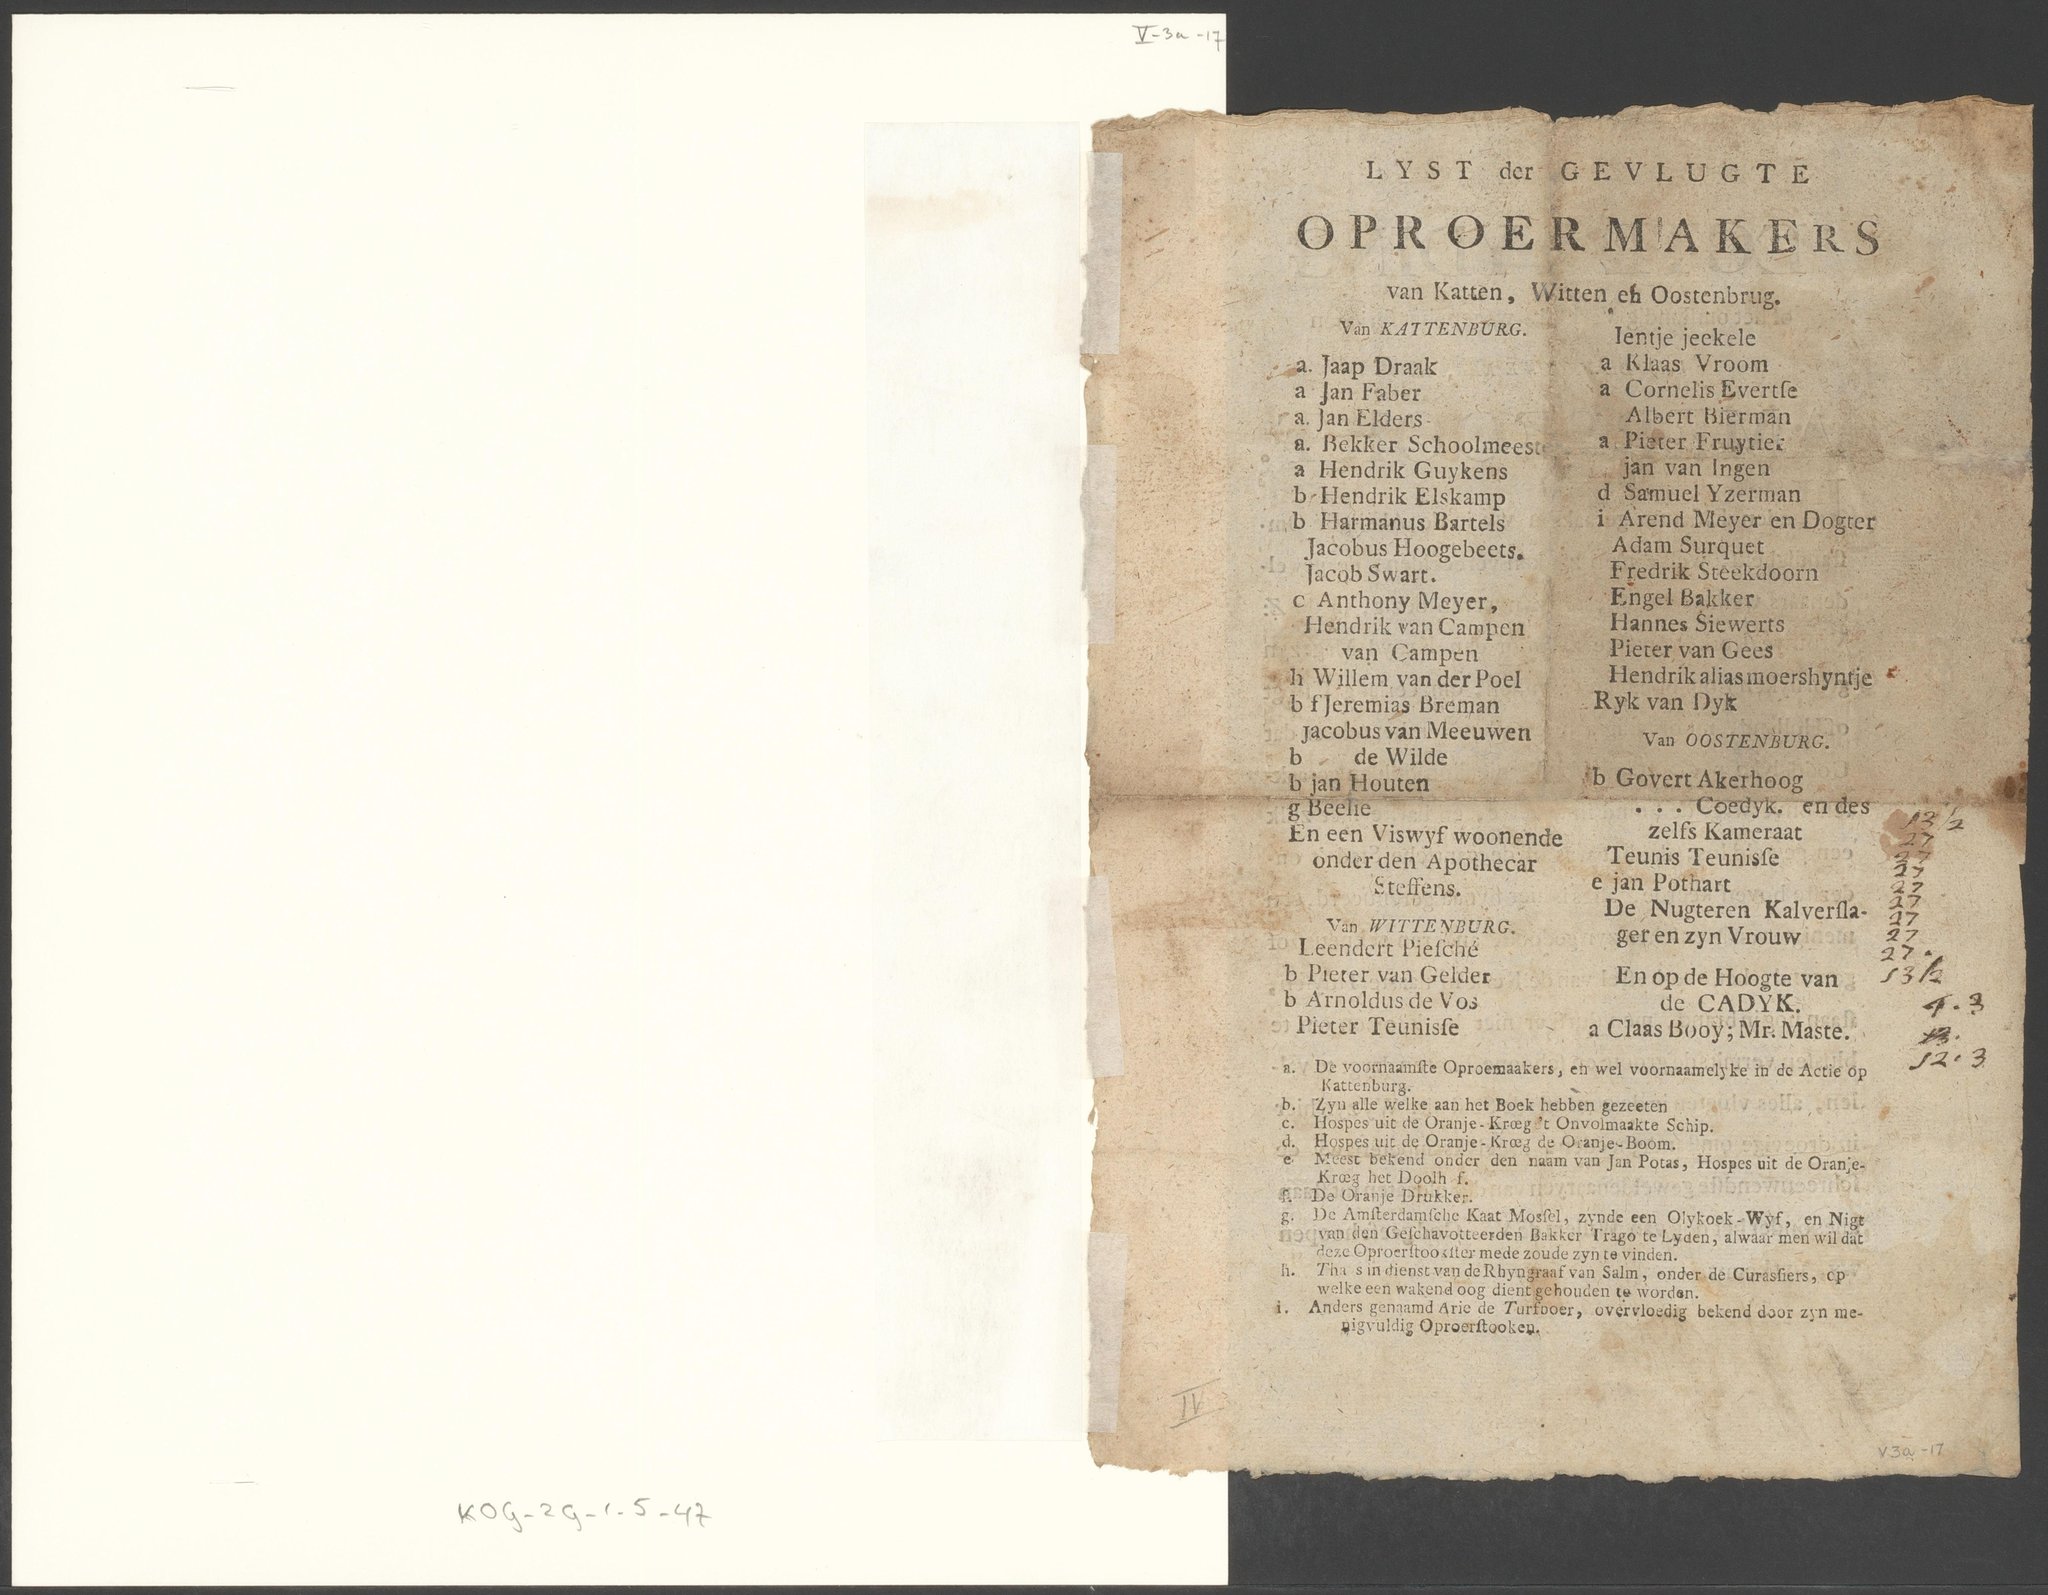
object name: text sheet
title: Lijst van gevluchte oproermakers, 1787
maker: Anonymous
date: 1787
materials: paper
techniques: letterpress printing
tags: wittenburg, oostenburg, kattenburg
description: Lijst van gevluchte oproermakers van een opstand in Kattenburg, Wittenburg en Oostenburg. In mei 1787 werd het Amsterdamse stadsbestuur door de patriotten weggestuurd. Inwoners kwamen in de opstand, de ophaalbrug naar Kattenburg werd opgehaald en de huizen en winkels van patriotten op het eiland werden geplunderd. Onderwerpsrubrieken binnen de Atlas Zeden en Gewoonten: Krijgswezen, Schutterij, Historieprenten.